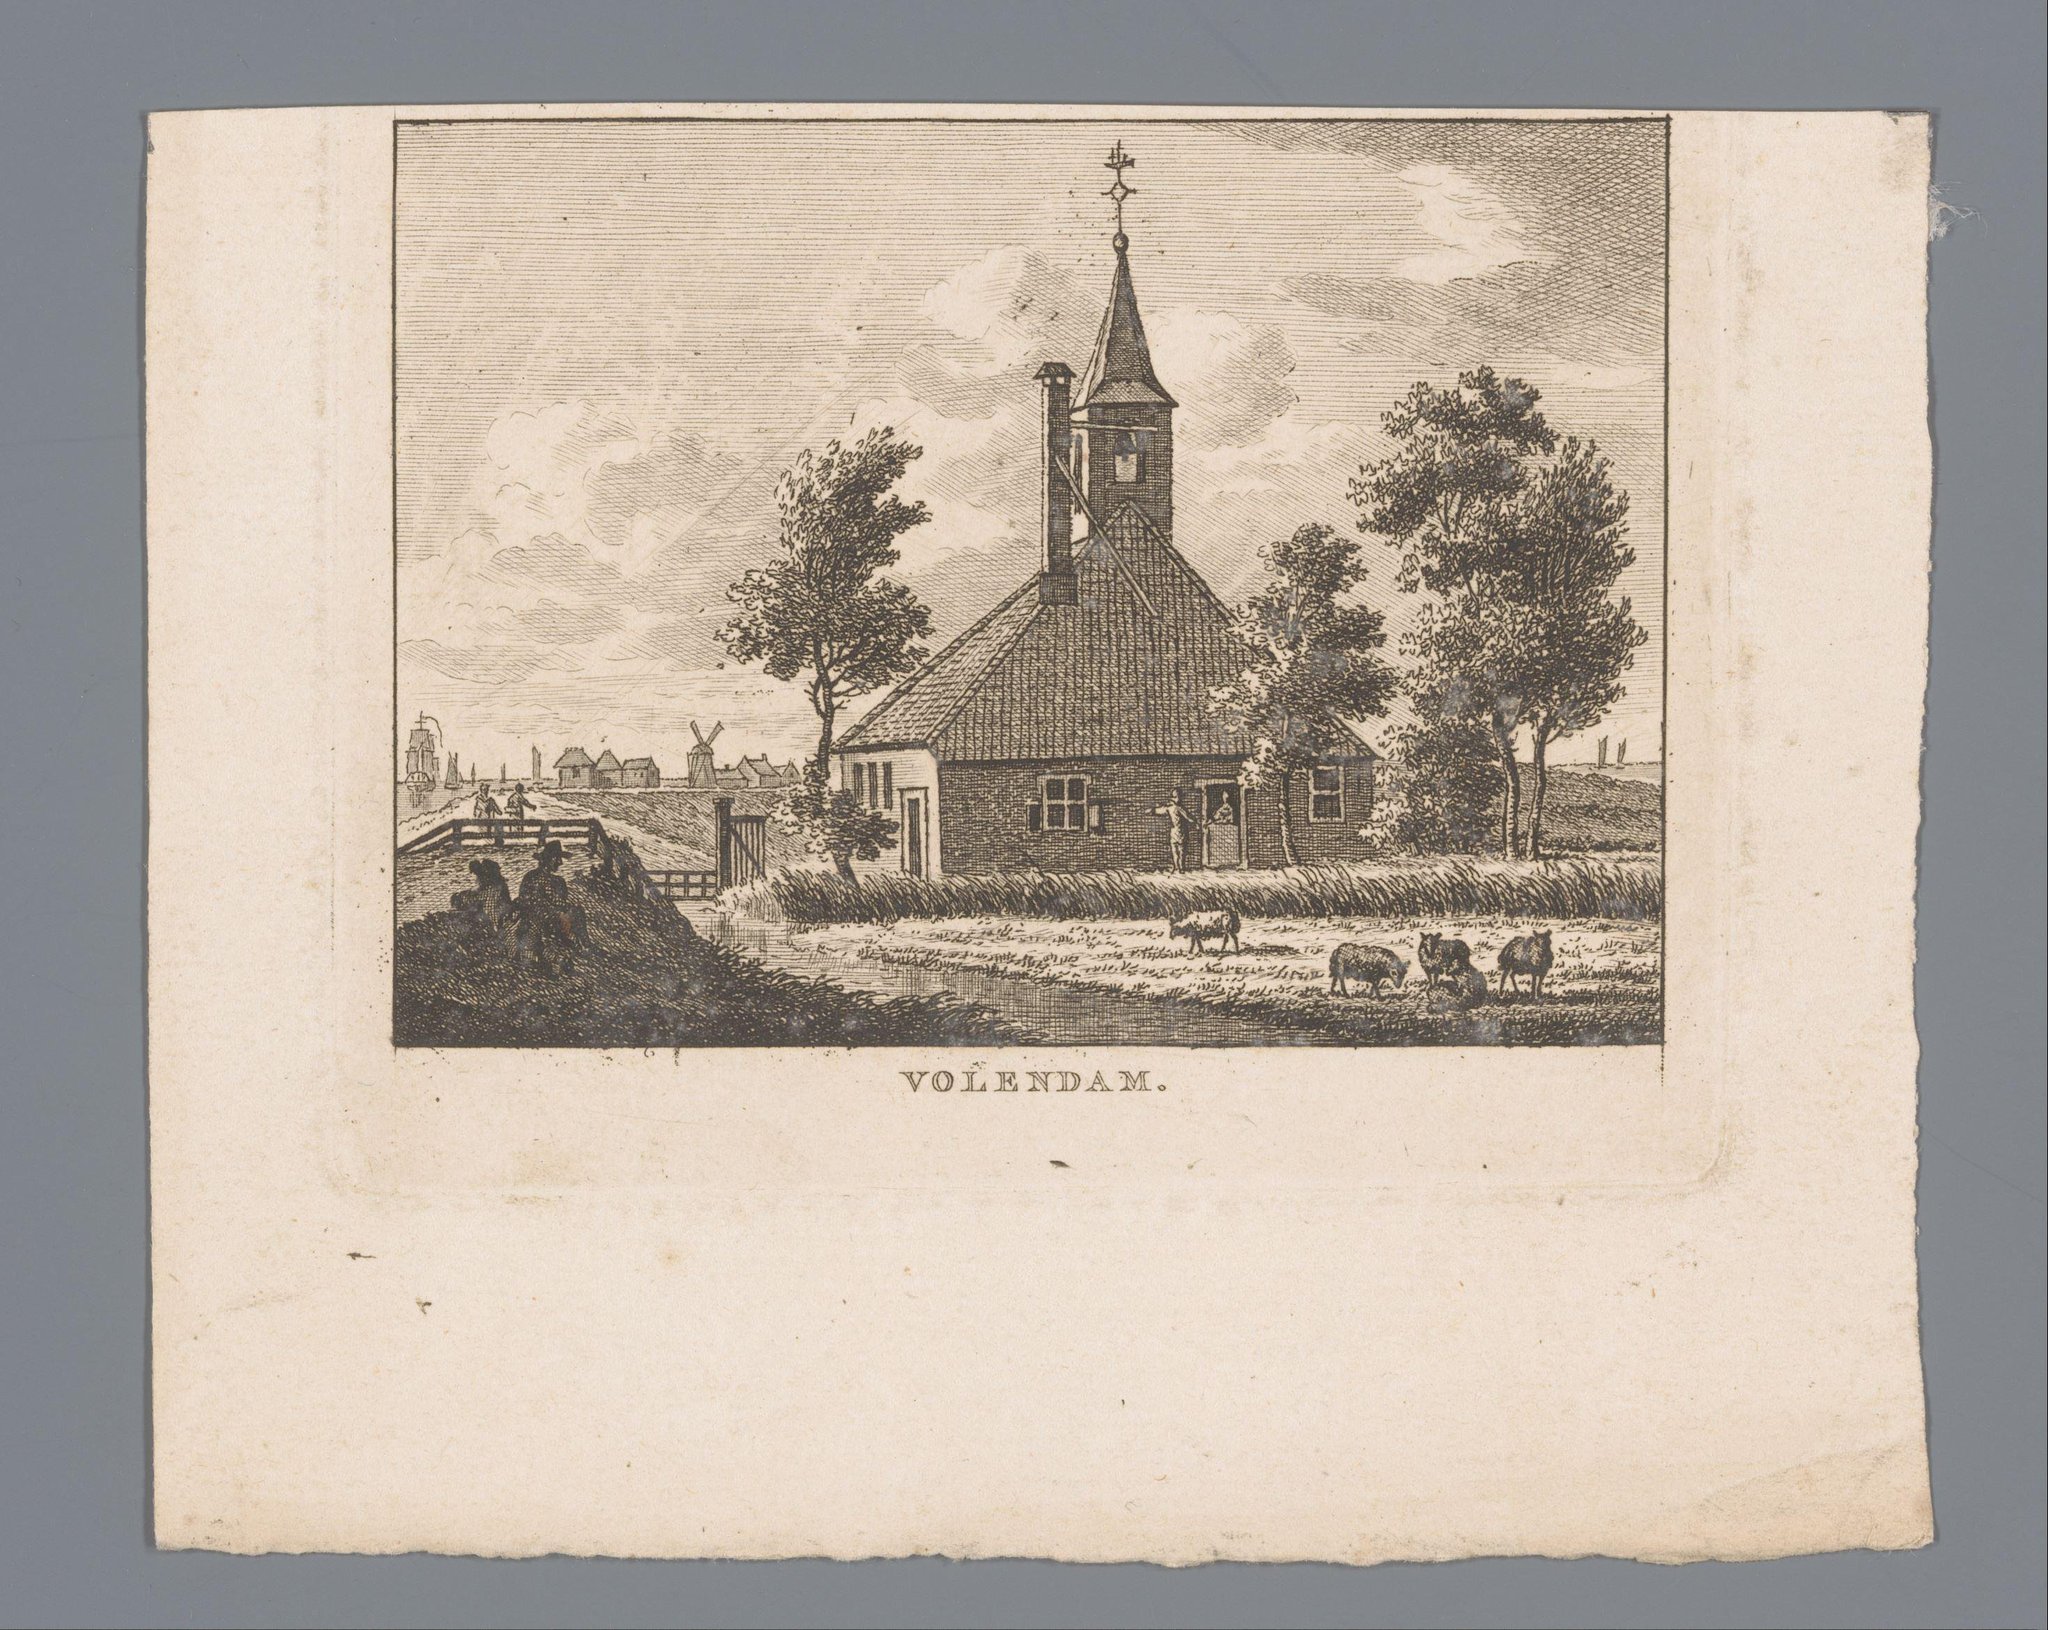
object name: print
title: Volendam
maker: carel frederik bendorp (i)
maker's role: print maker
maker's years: 1736-1814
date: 1786-1792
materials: paper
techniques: etching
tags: protestant churches and denominations, city-view, and landscape with man-made constructions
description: Prent uit: Vaderlandsche gezichten, of afbeeldingen van den tegenwoordigen staat der Vereenigde Nederlanden (…). Amsterdam: Hendrik Gartman, Willem Vermandel en Jan Willem Smit, 1786-1792. Uitgegeven in afleveringen met ieder een eigen bifolium en inhoudsopgave. Alle prenten in deze publicatie zijn gegraveerd door Carel Frederik Bendorp (I) en, in de meeste gevallen, gebaseerd op tekeningen van Jan Bulthuis.